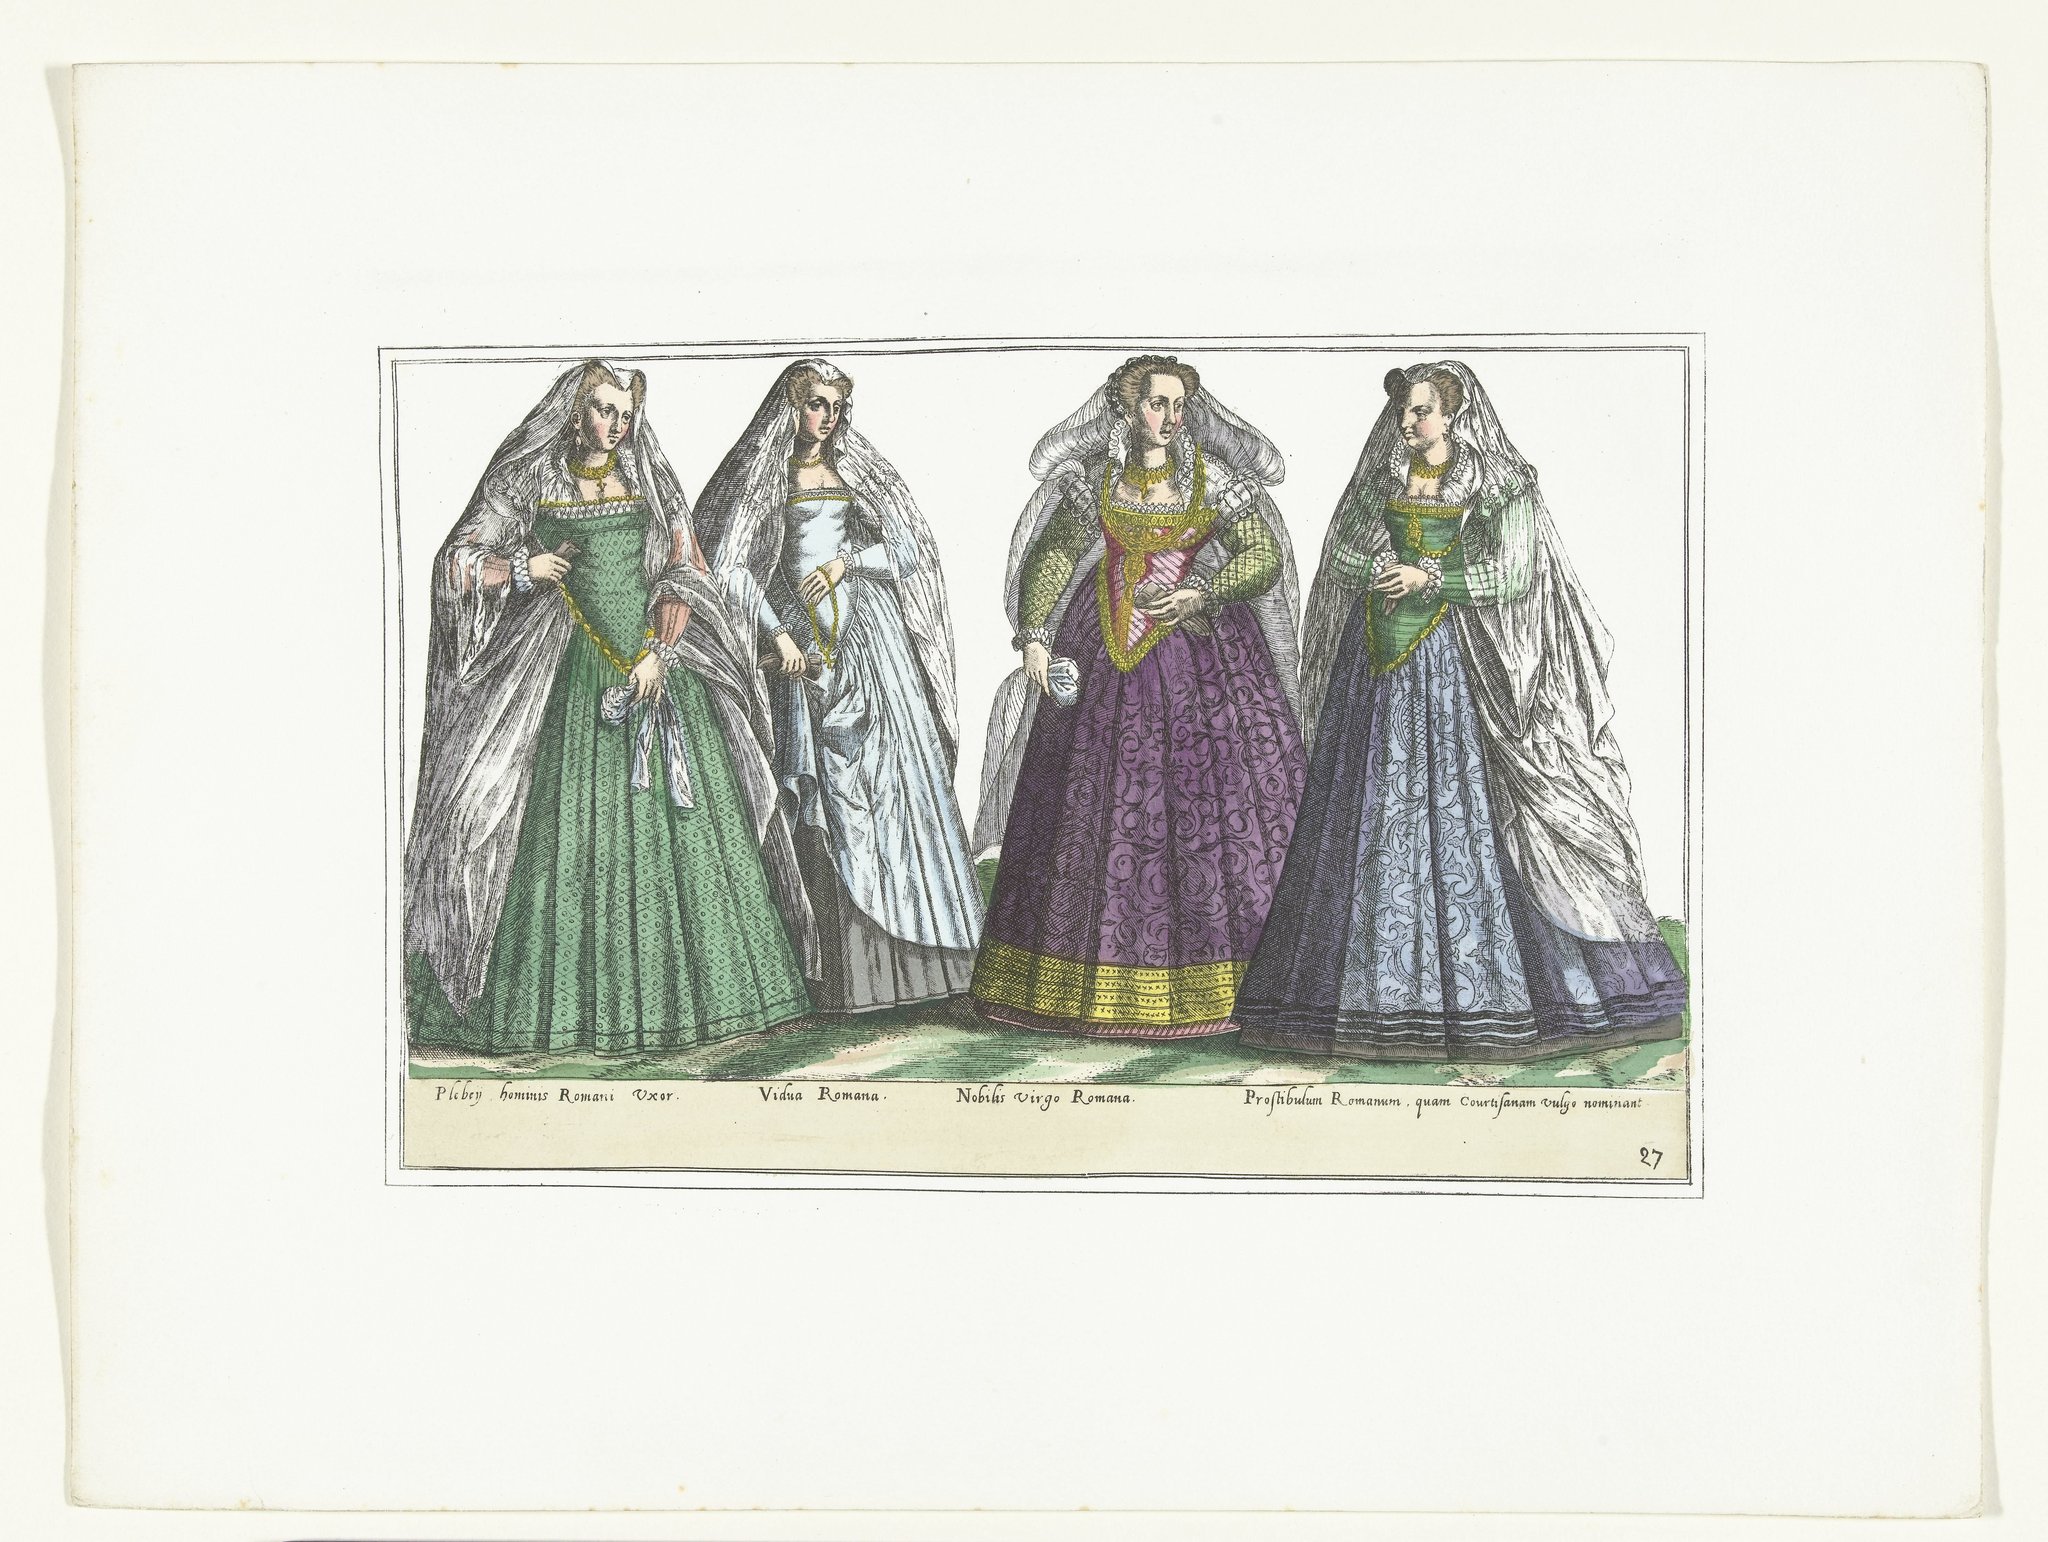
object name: print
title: Costumes Italiens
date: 1872-1875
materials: paper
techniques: hand coloring, printing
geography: belgium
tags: clothes, costume (+ women's clothes), rome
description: Onderdeel van Costumes civils et militaires du XVIe siècle par A. de Bruyn, een selectie van prenten uit de Trachtenbuch van Abraham de Bruyn uit 1581 (Hollstein 248-306), in facsimile. Losbladig uitgegeven met titelbladen, verklaring en lijst van de platen door G.A. van Trigt te Brussel in 1875 met teksten van Auguste Schoy. In de Rijksmuseum Research Library met signatuur 34 C 43.